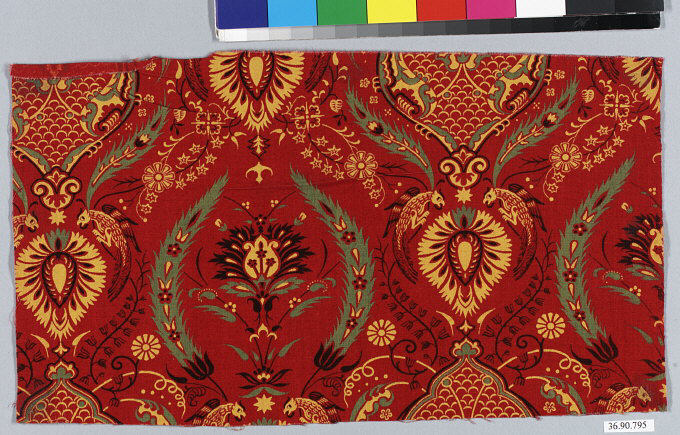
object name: piece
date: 1867-1900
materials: cotton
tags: birds,flowers